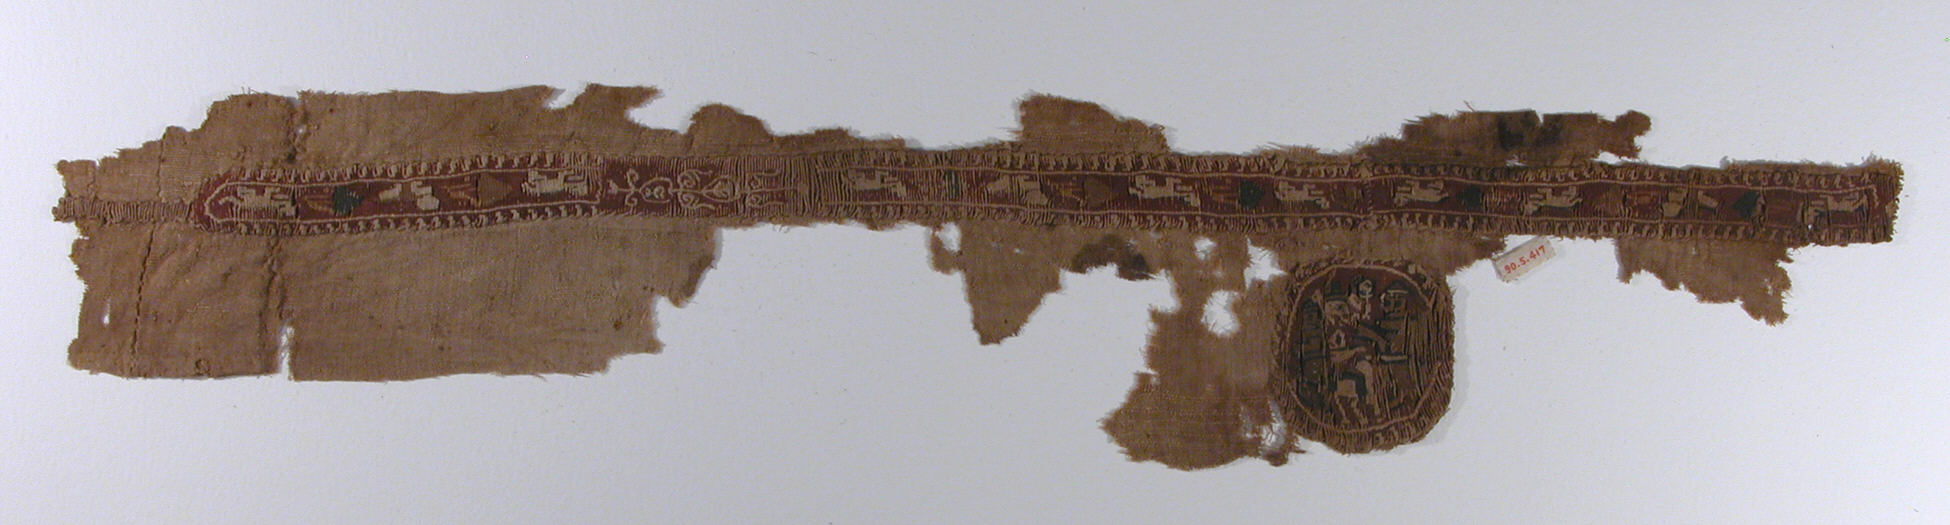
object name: textile fragment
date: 401-600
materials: linen, wool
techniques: weave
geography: egypt